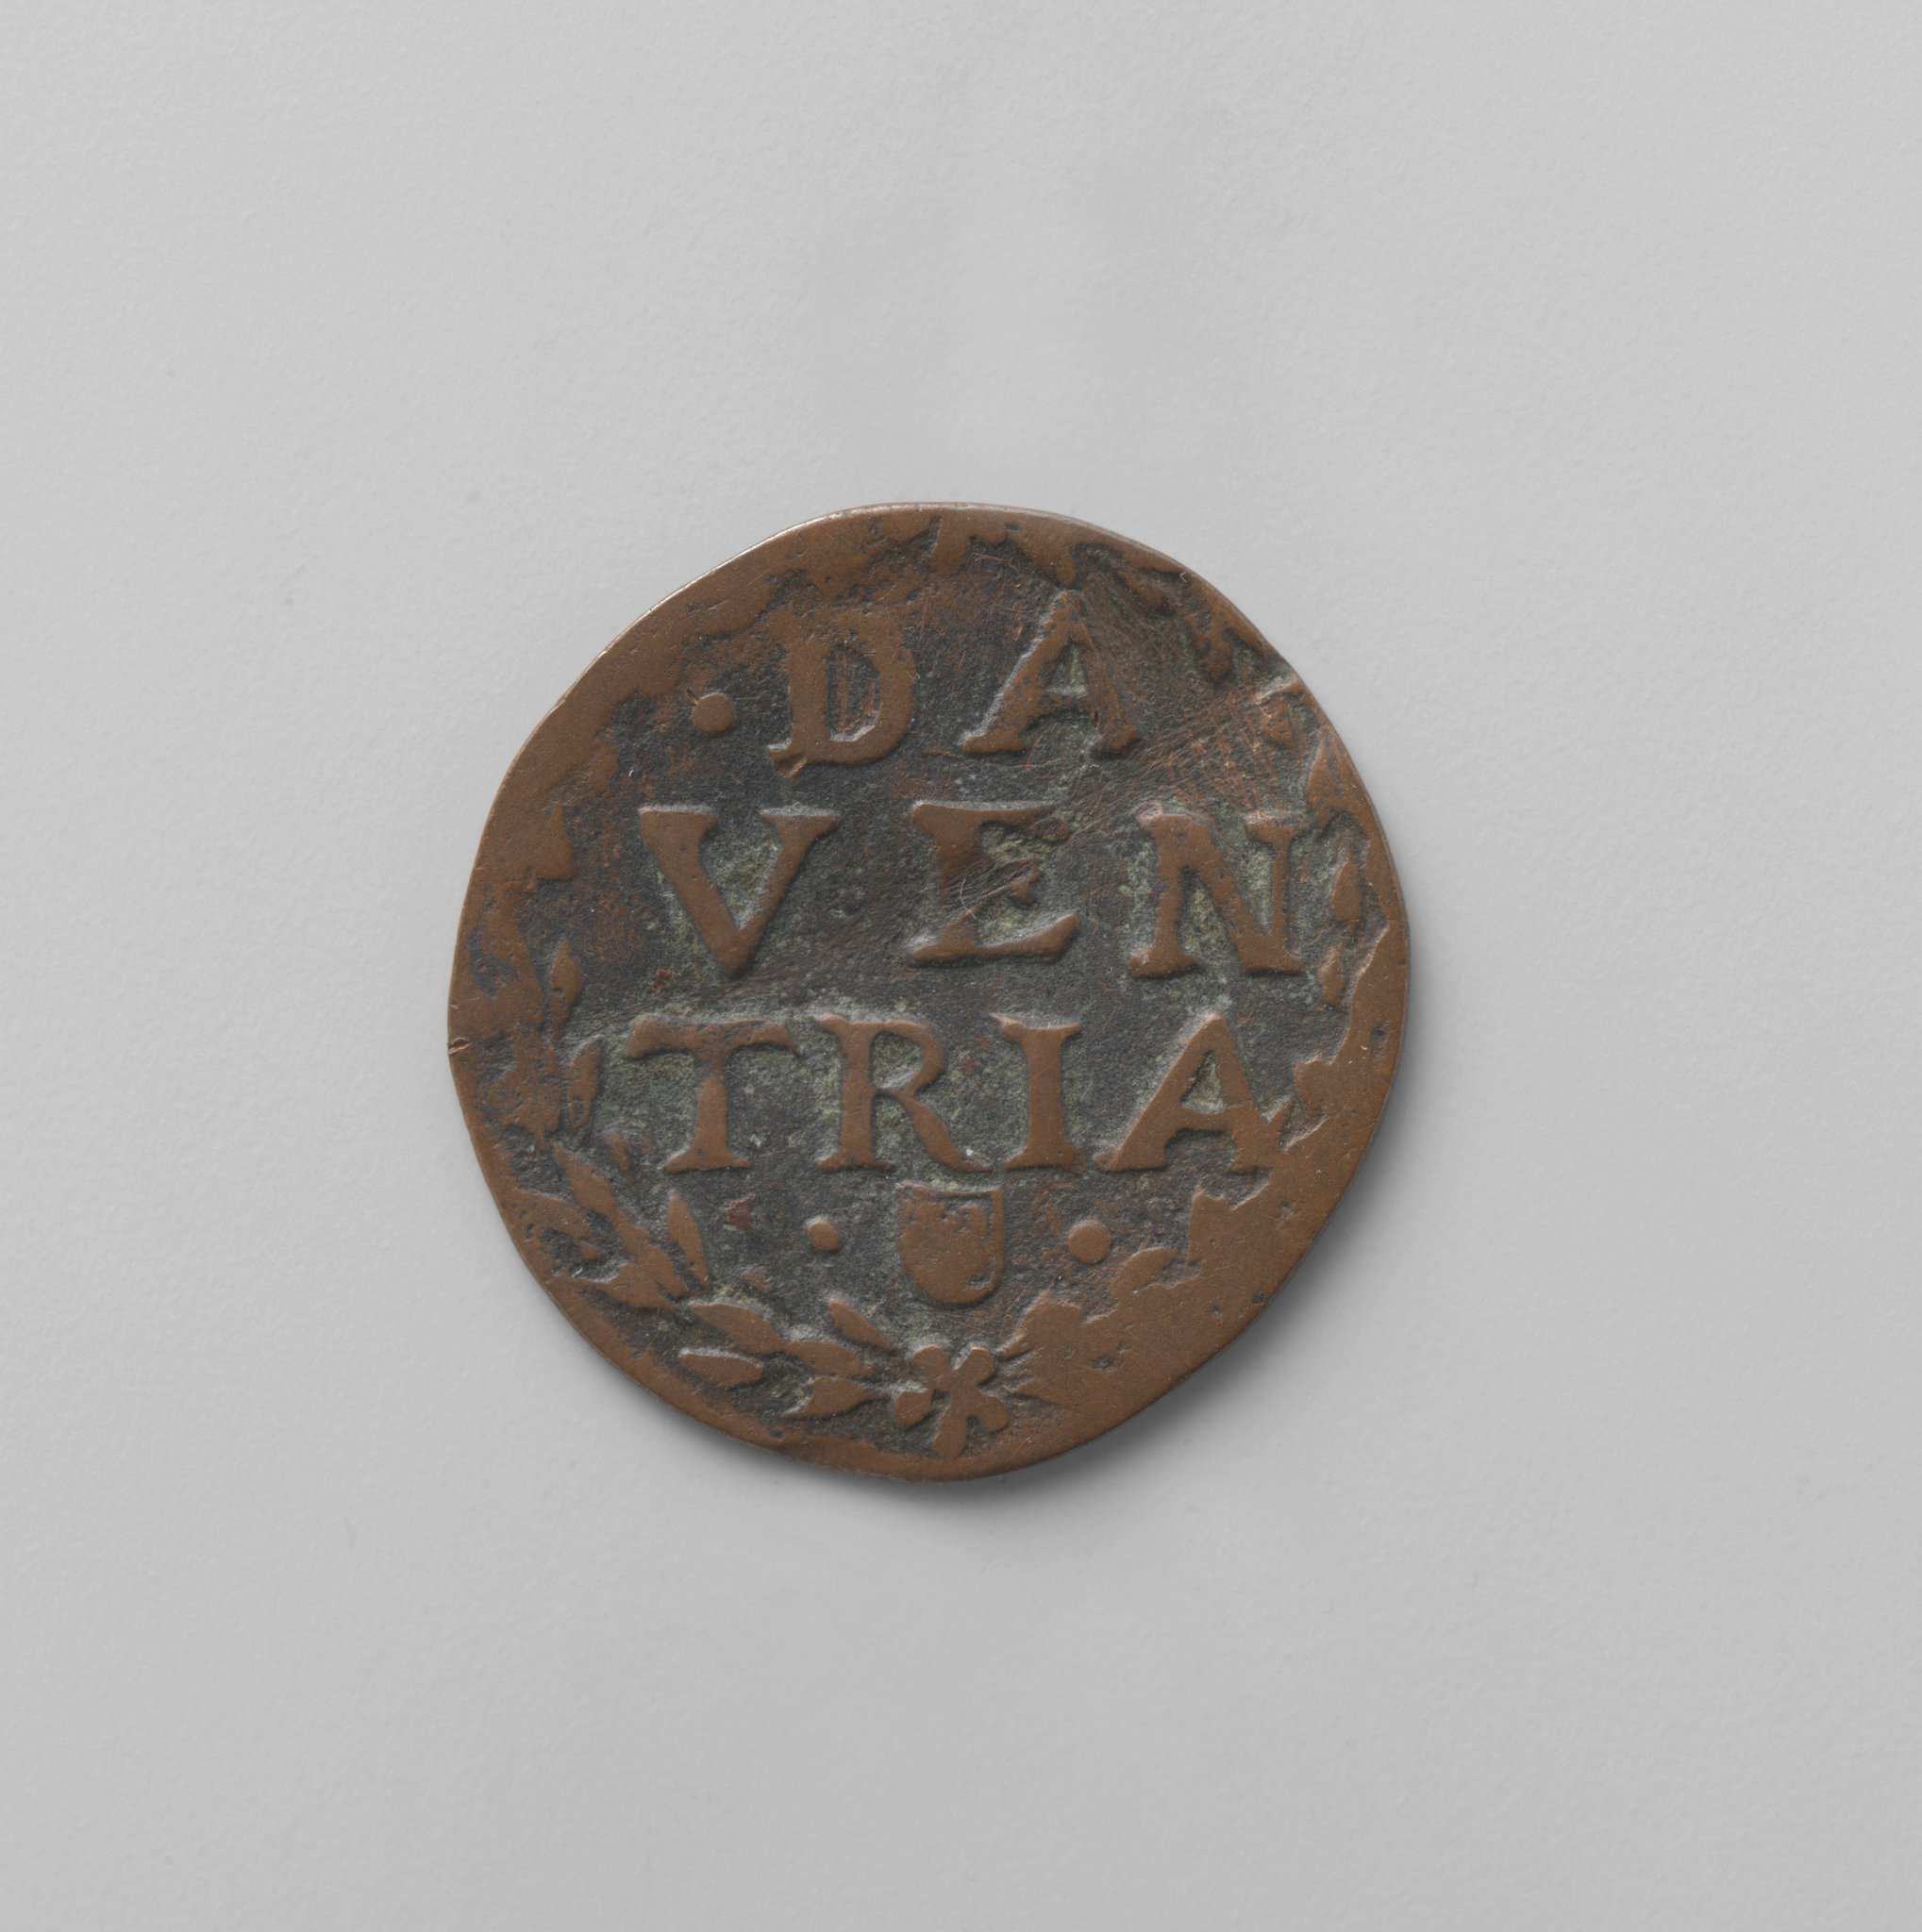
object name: coin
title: Deventer, duit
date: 1627-1629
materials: copper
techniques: striking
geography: deventer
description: Koperen munt. Voorzijde: gekroond wapenschild van Deventer. Keerzijde: binnen een bladerkrans drieregelig opschrift, waaronder wapenschild.